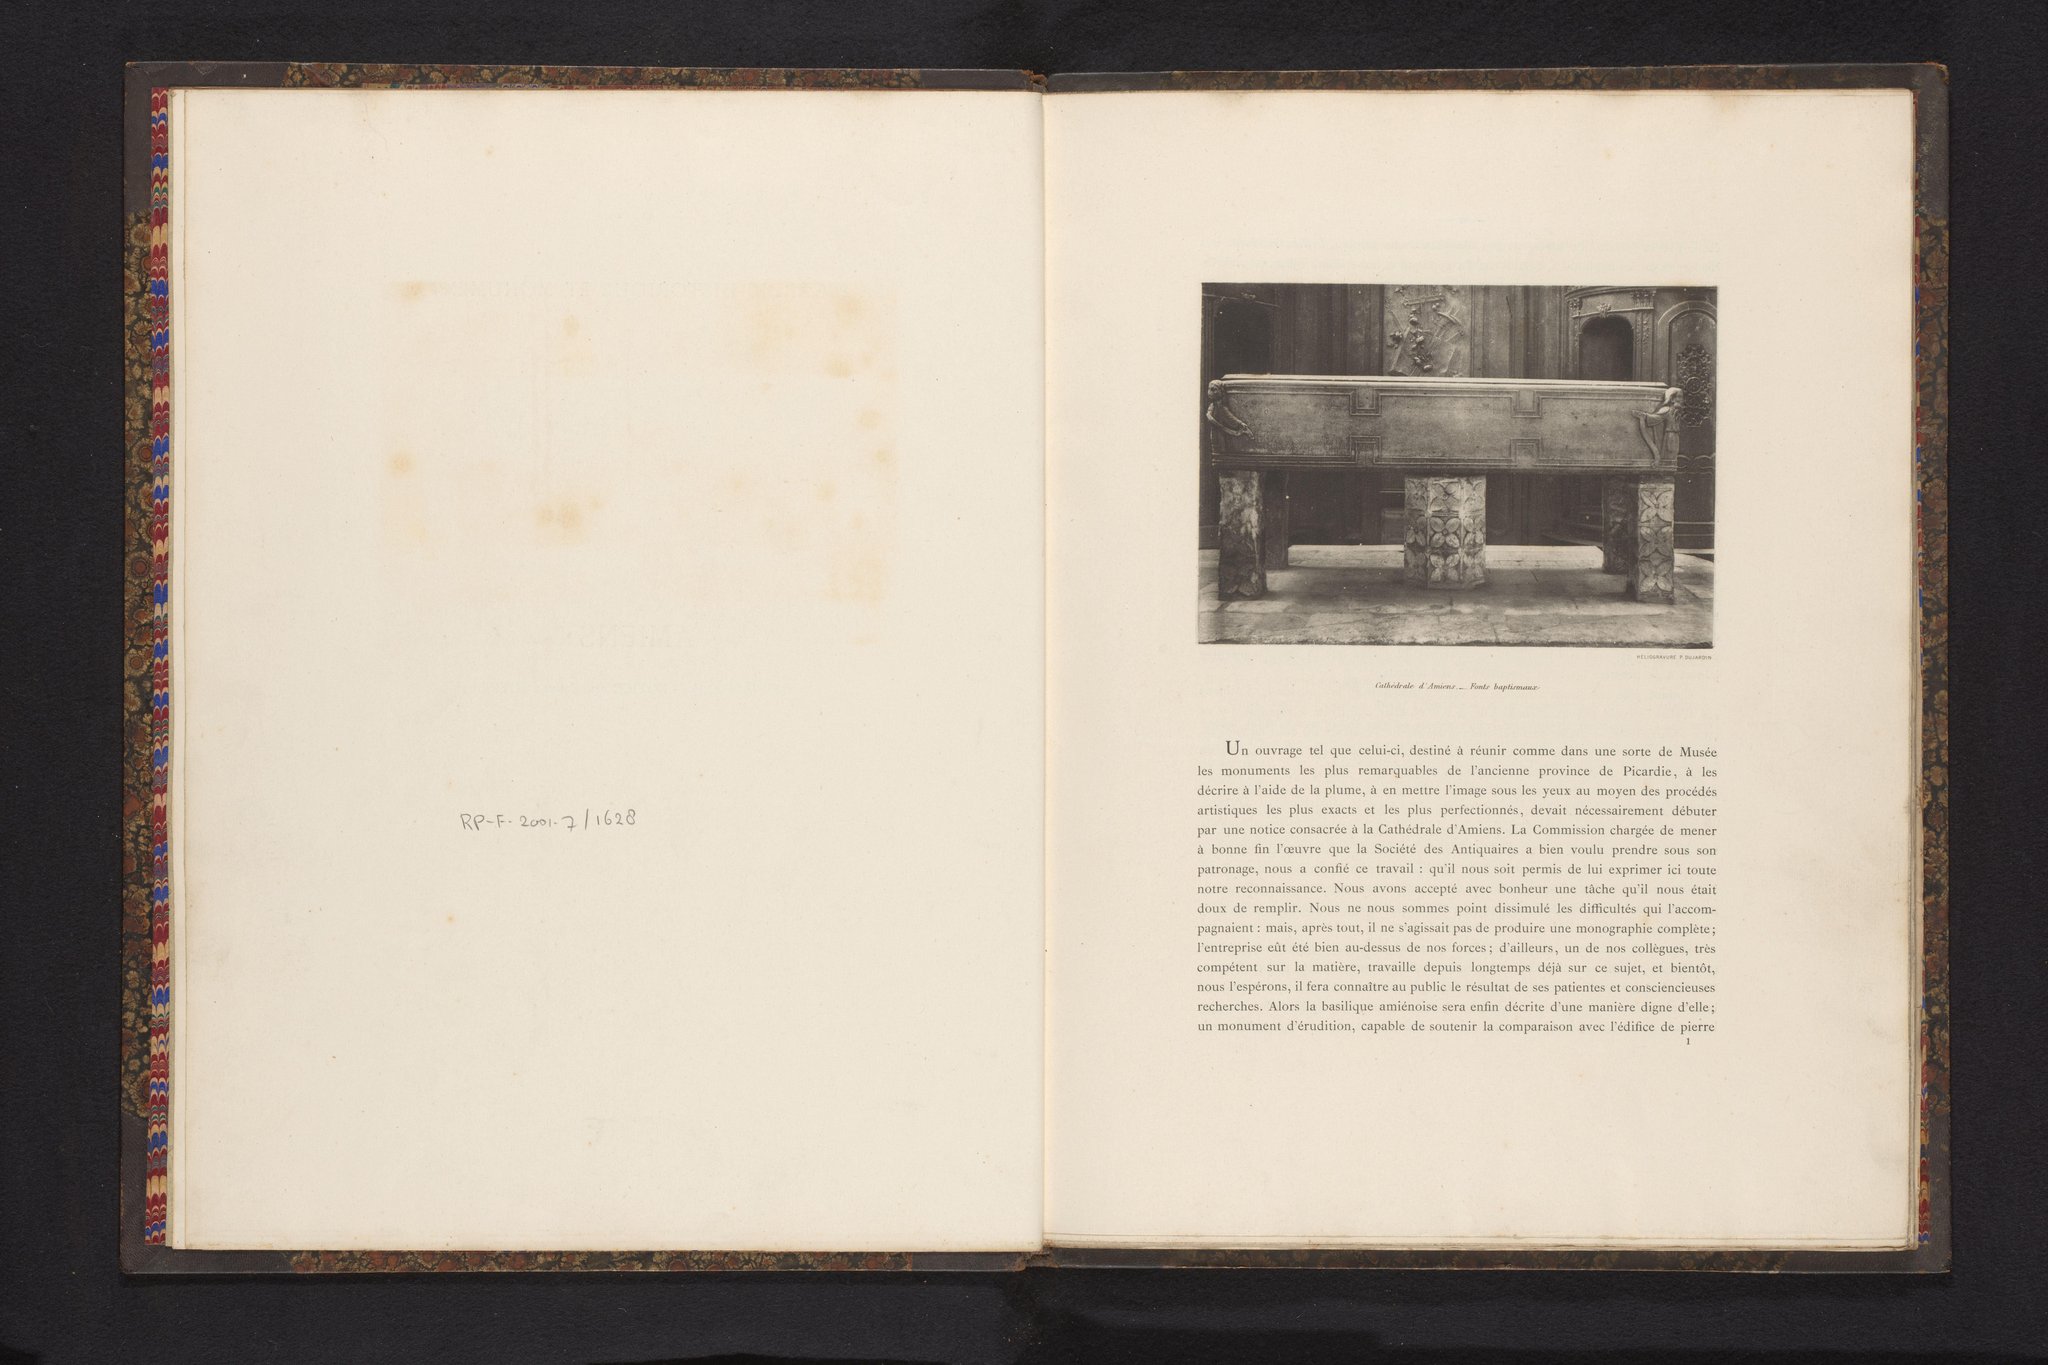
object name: page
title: Doopvont in de Notre-Dame van Amiens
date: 1888-1893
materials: paper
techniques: photograph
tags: baptismal font, notre-dame d'amiens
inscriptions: inscription: ‘Cathédrale d'Amiens - Fonts baptismaux’